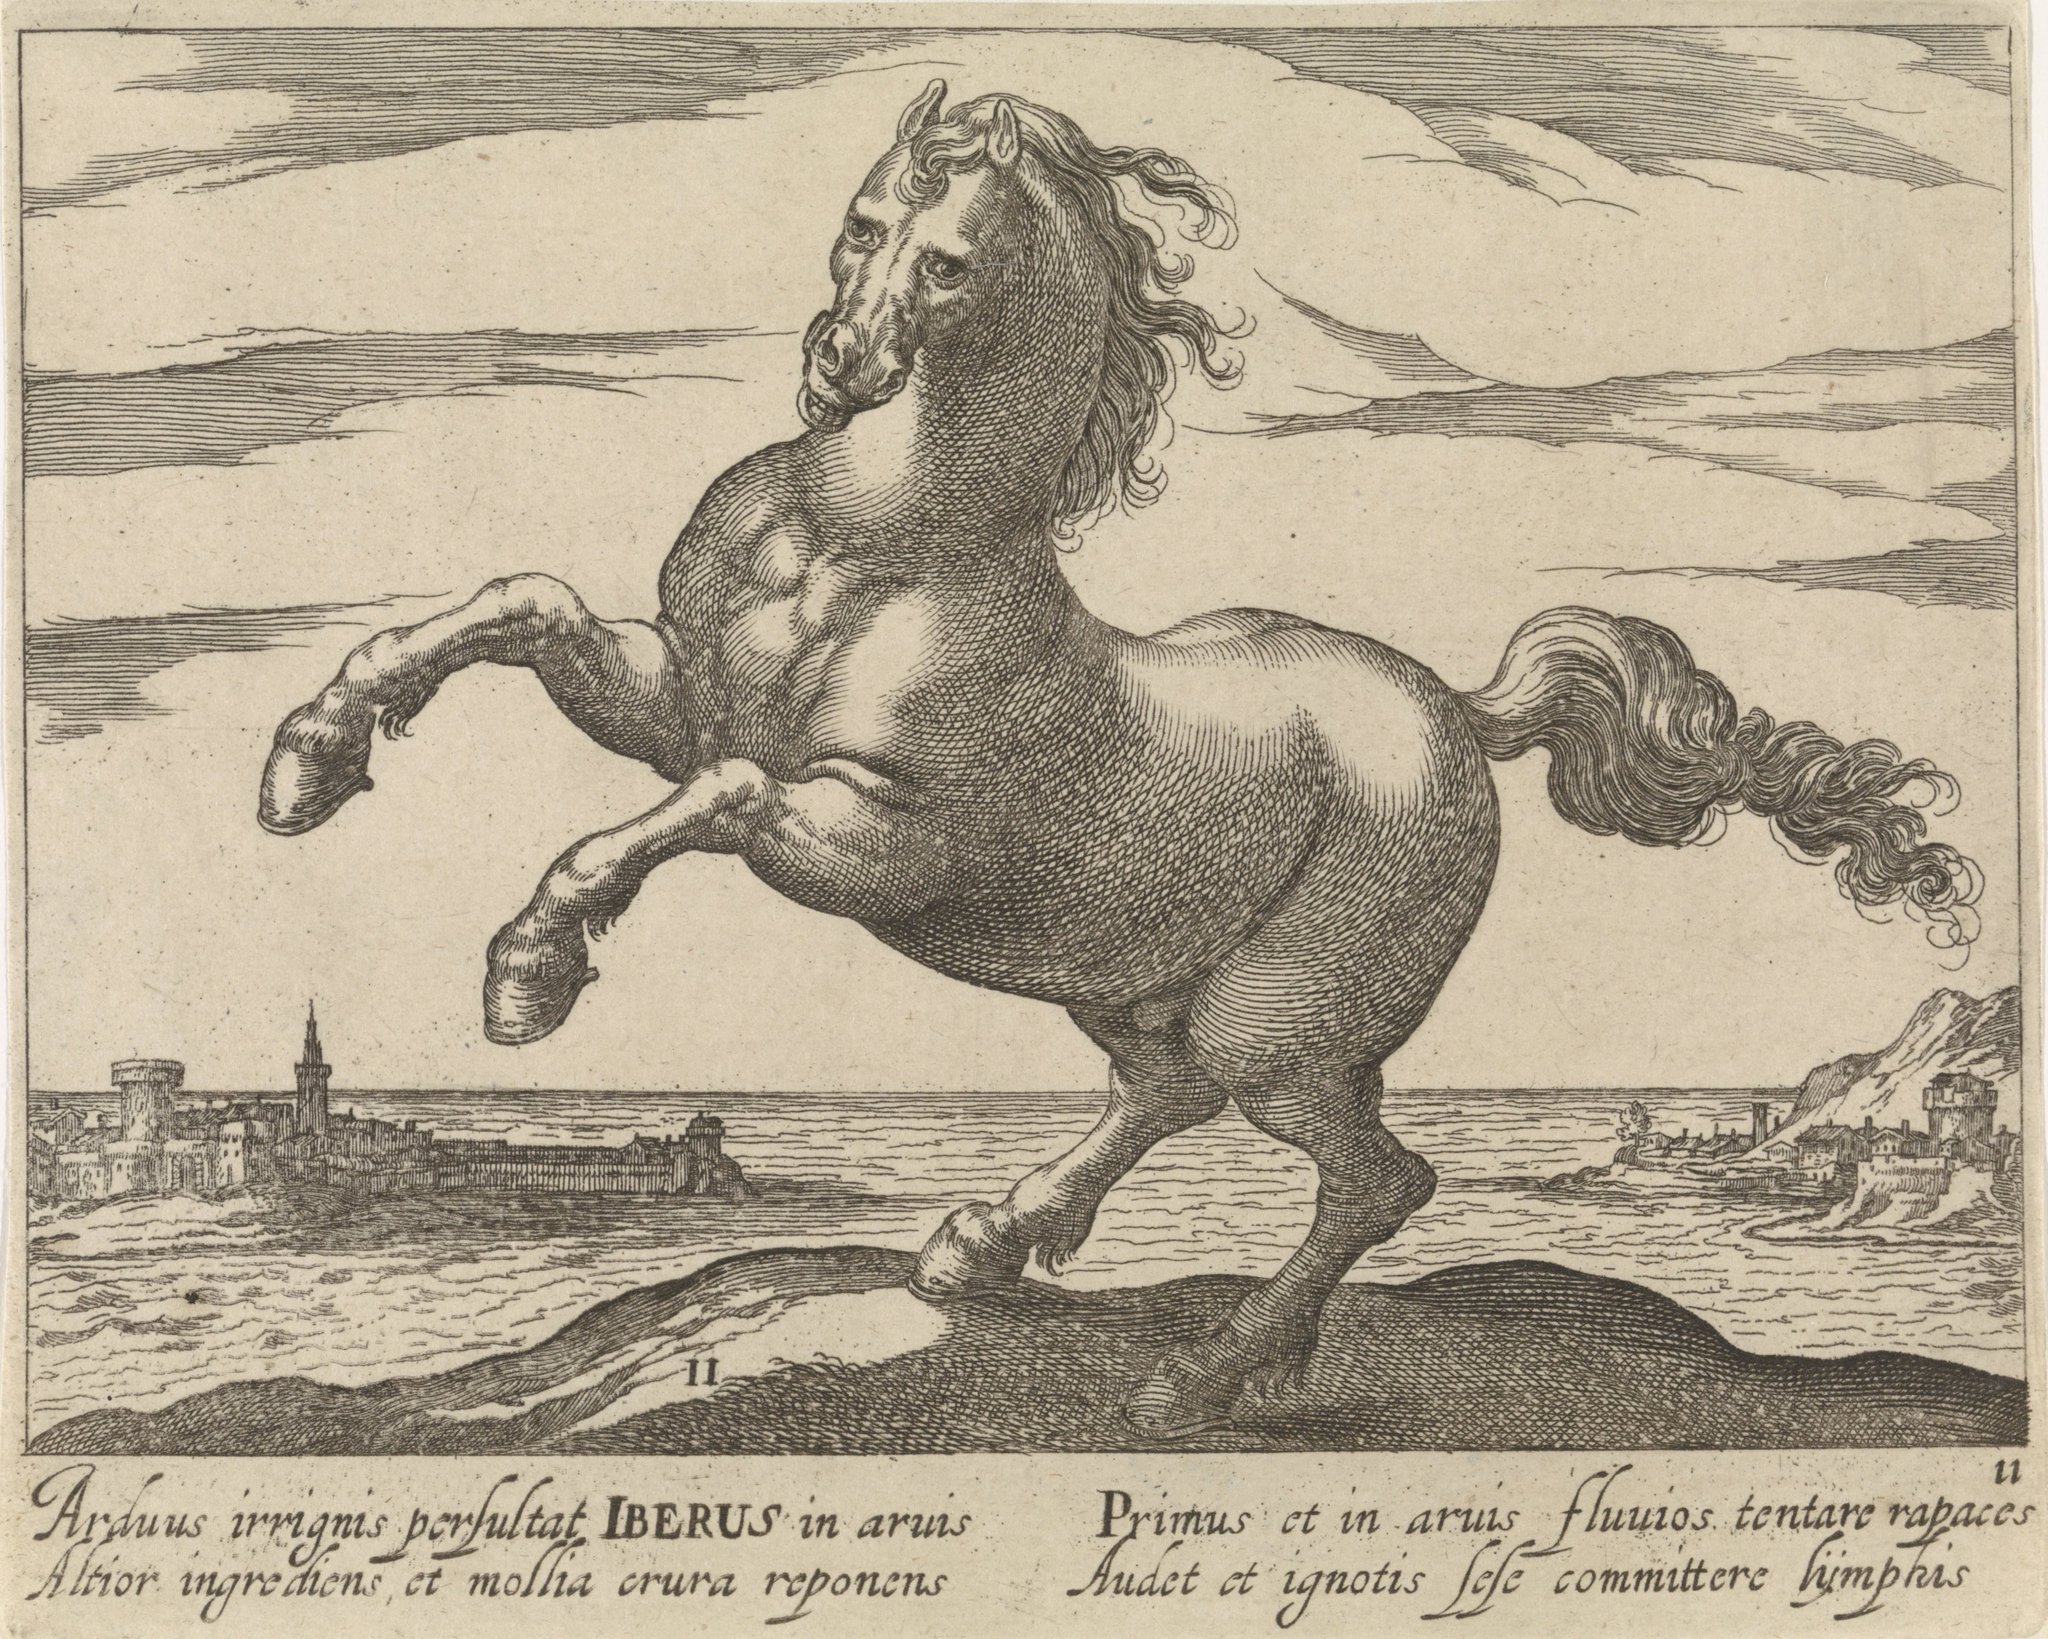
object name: print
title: Paardenrassen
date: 1590-1637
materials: paper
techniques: engraving, etching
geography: amsterdam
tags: horse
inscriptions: collector's mark: Lugt 2228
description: Heuvelachtig landschap met steigerend paard, naar links gewend, aan de kust. In de marge een tweeregelig onderschrift in het Latijn. Prent uit een serie van dertig met paardenrassen.